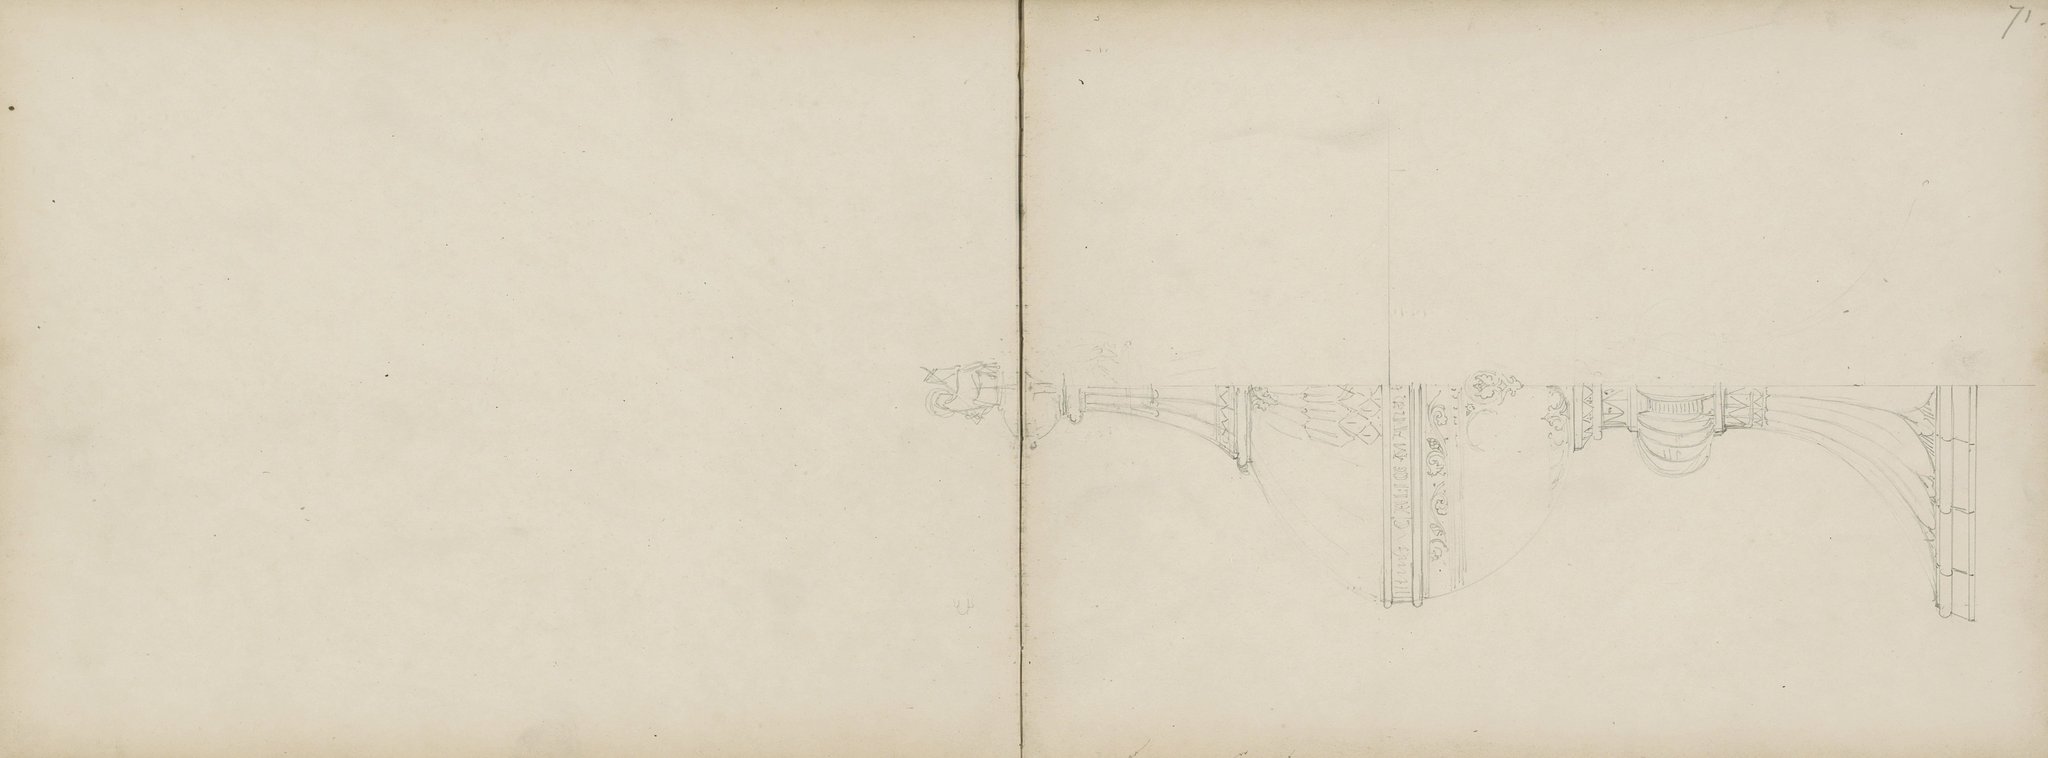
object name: sketchbook leaf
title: Ciborie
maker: pierre joseph hubert cuypers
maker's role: draughtsman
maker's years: 1827-1921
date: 1857-1859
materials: paper, pencil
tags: ciborium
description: Blad 70 verso en 71 recto uit een schetsboek met 77 bladen.